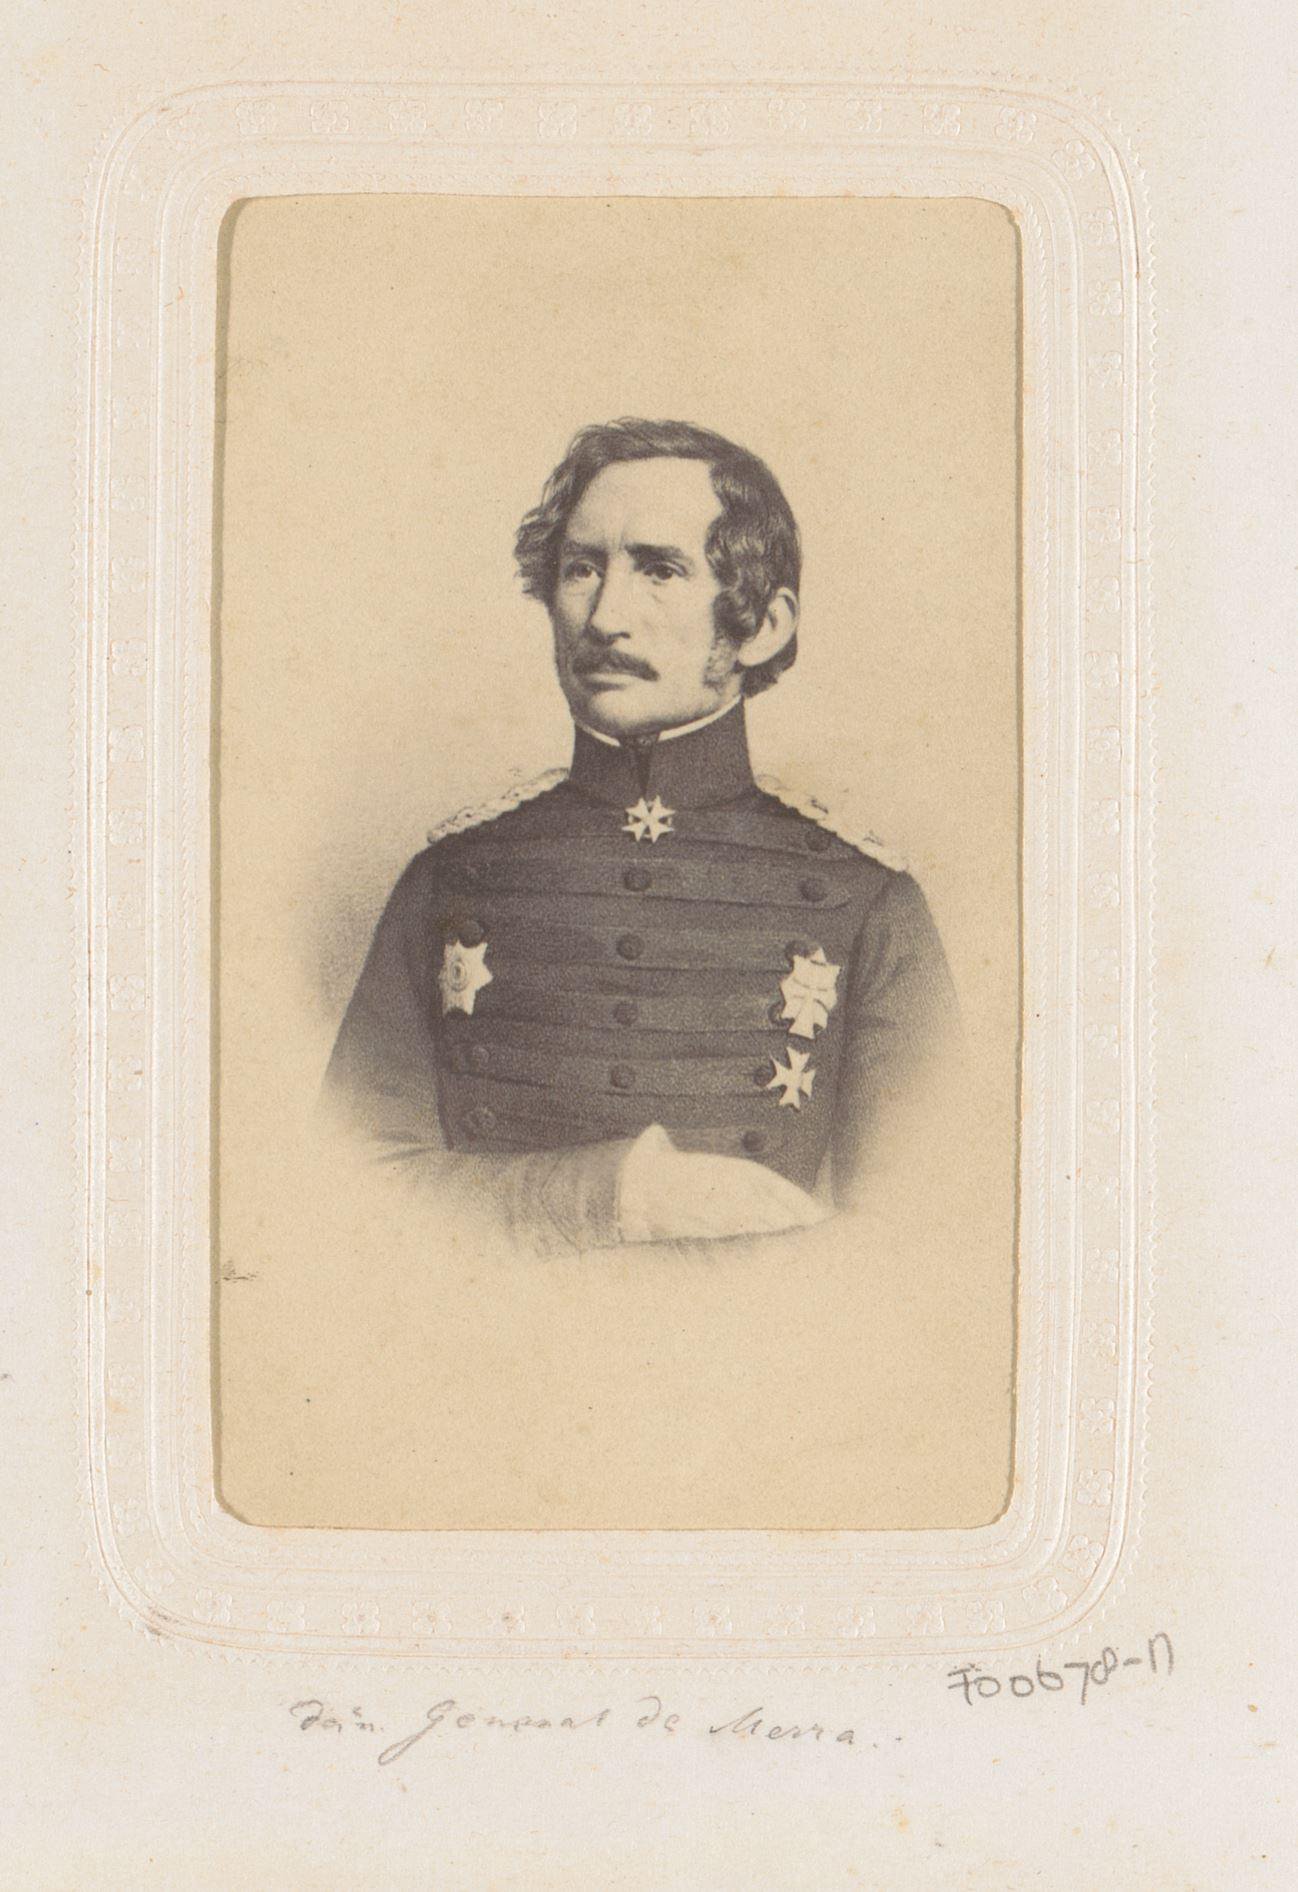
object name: album leaf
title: Portret van een Deense generaal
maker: Anonymous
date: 1860-1880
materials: cardboard, photographic support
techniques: albumen print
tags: commander-in-chief, general, marshal, historical persons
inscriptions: annotation: ‘Danische General de Merra’